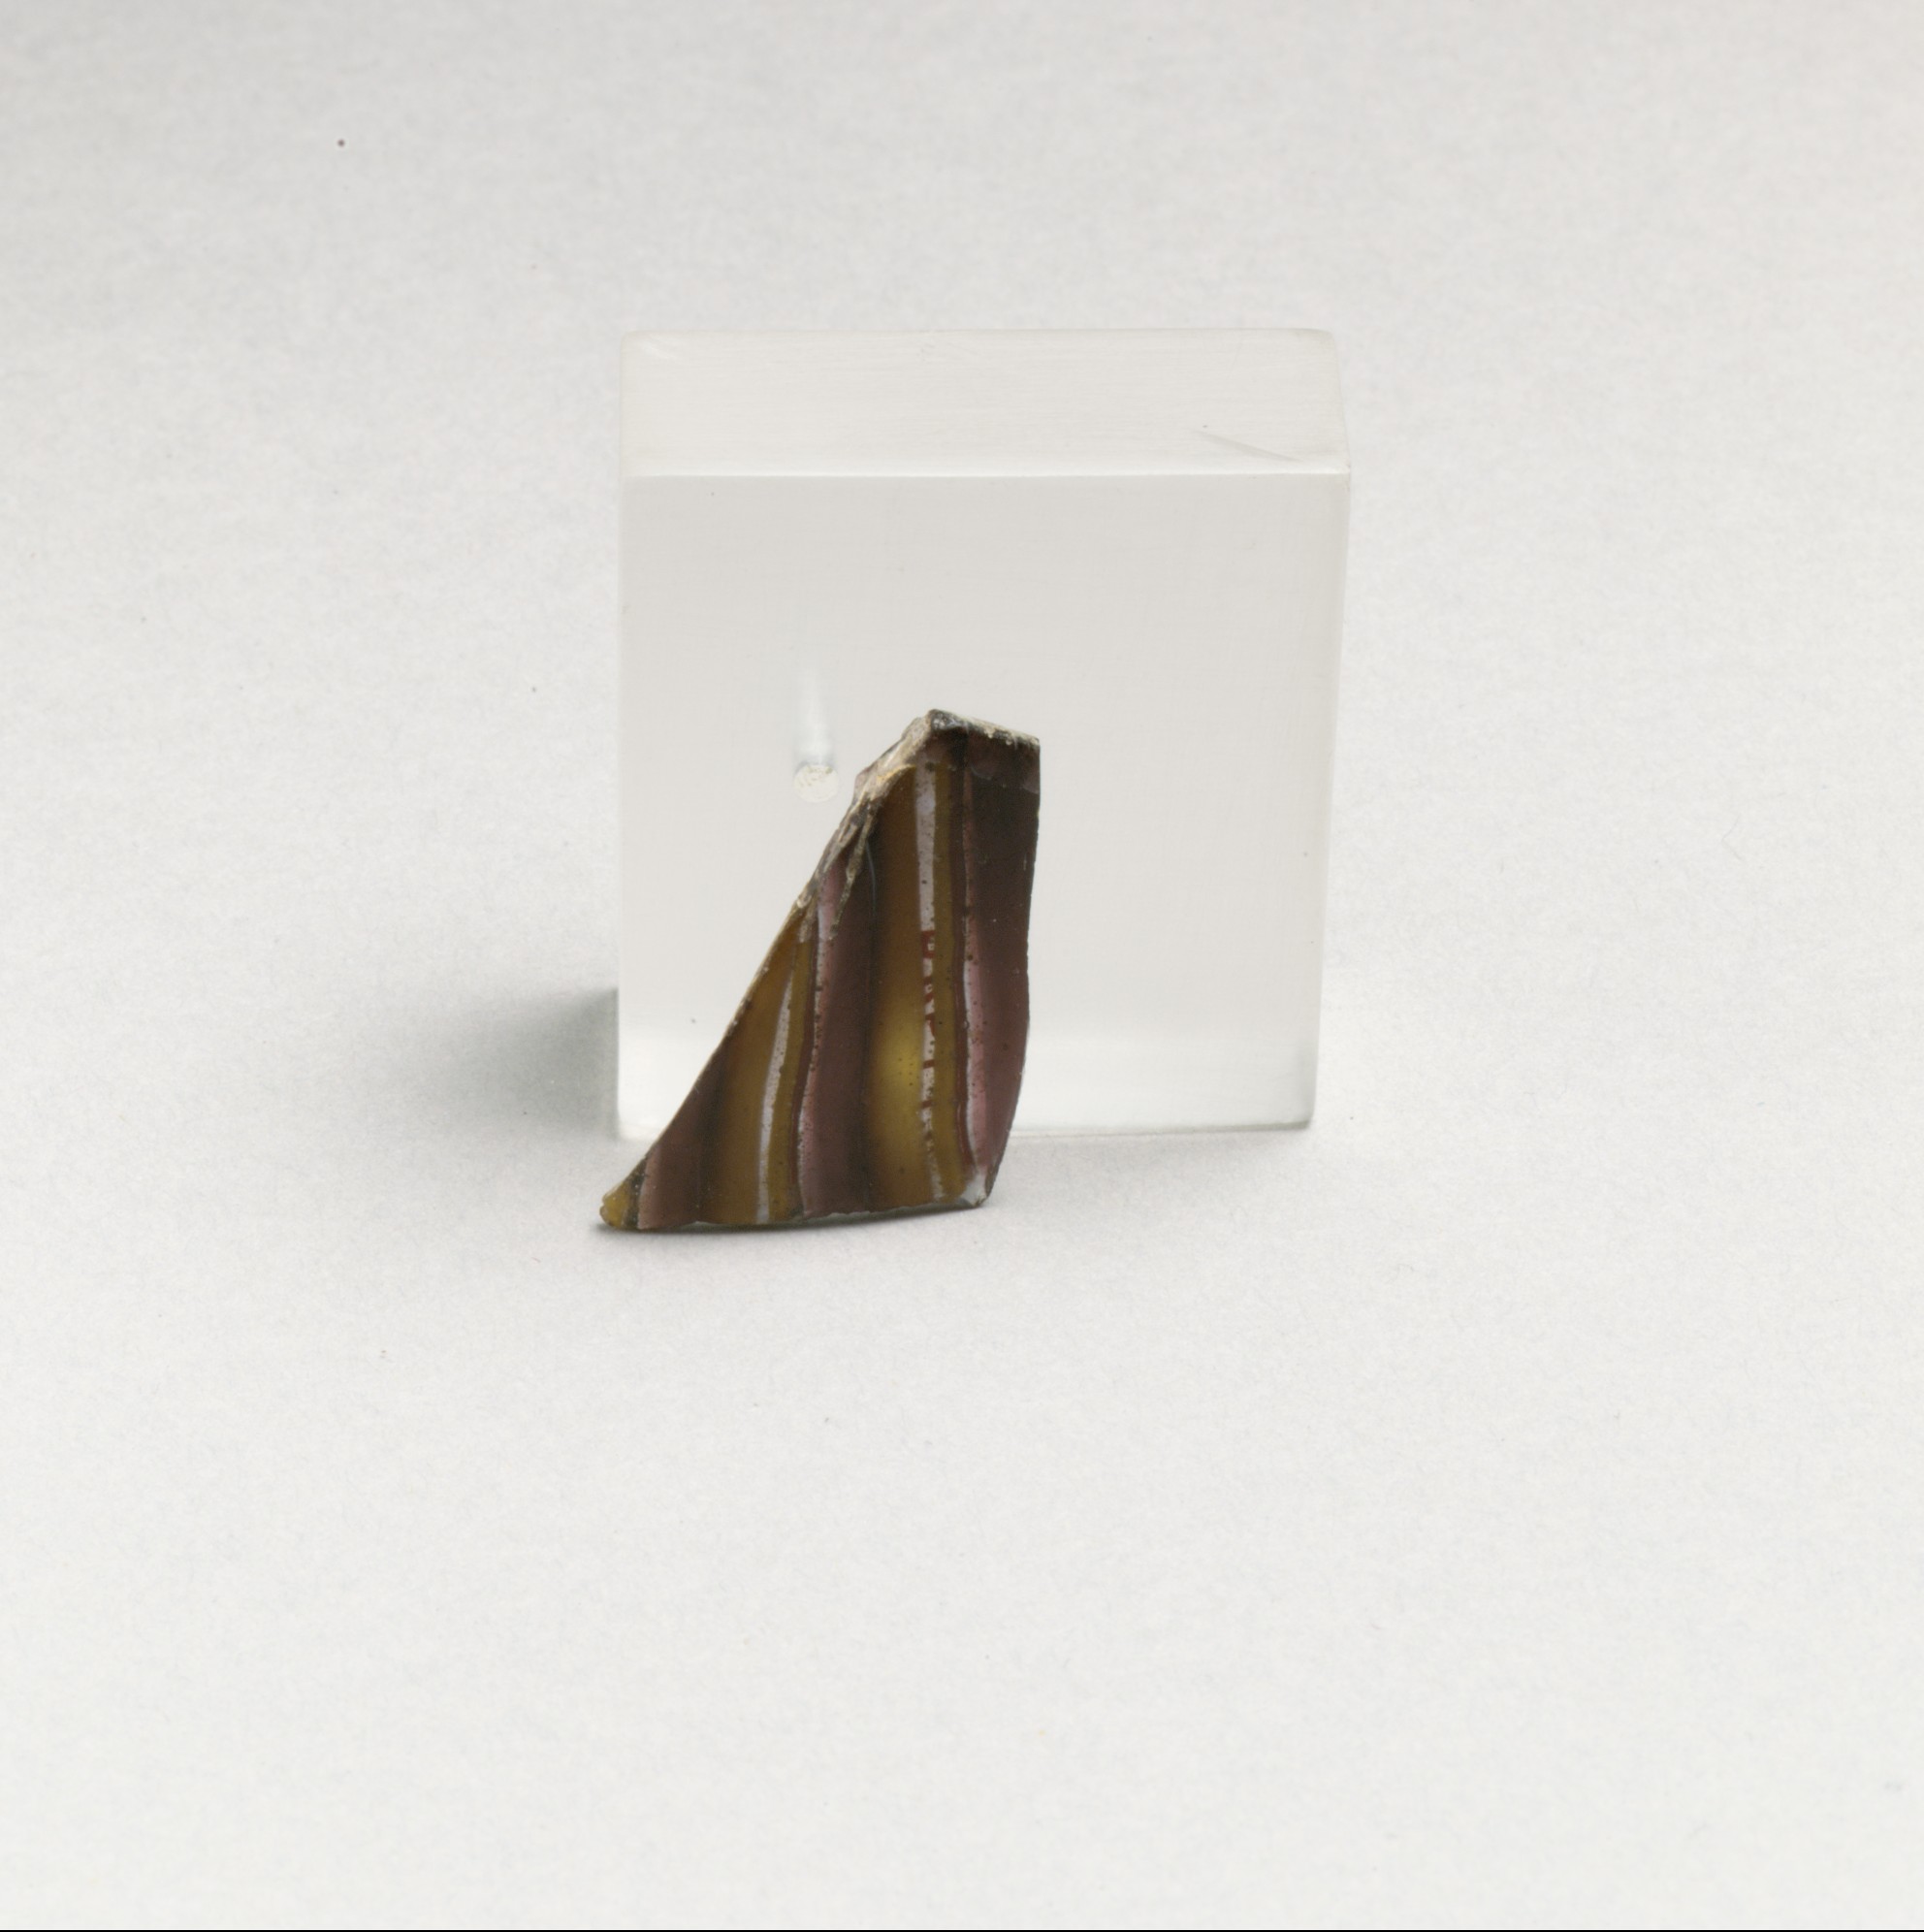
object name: fragment, mosaic bowl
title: Glass mosaic bowl fragment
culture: roman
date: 34 BCE-33 CE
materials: glass